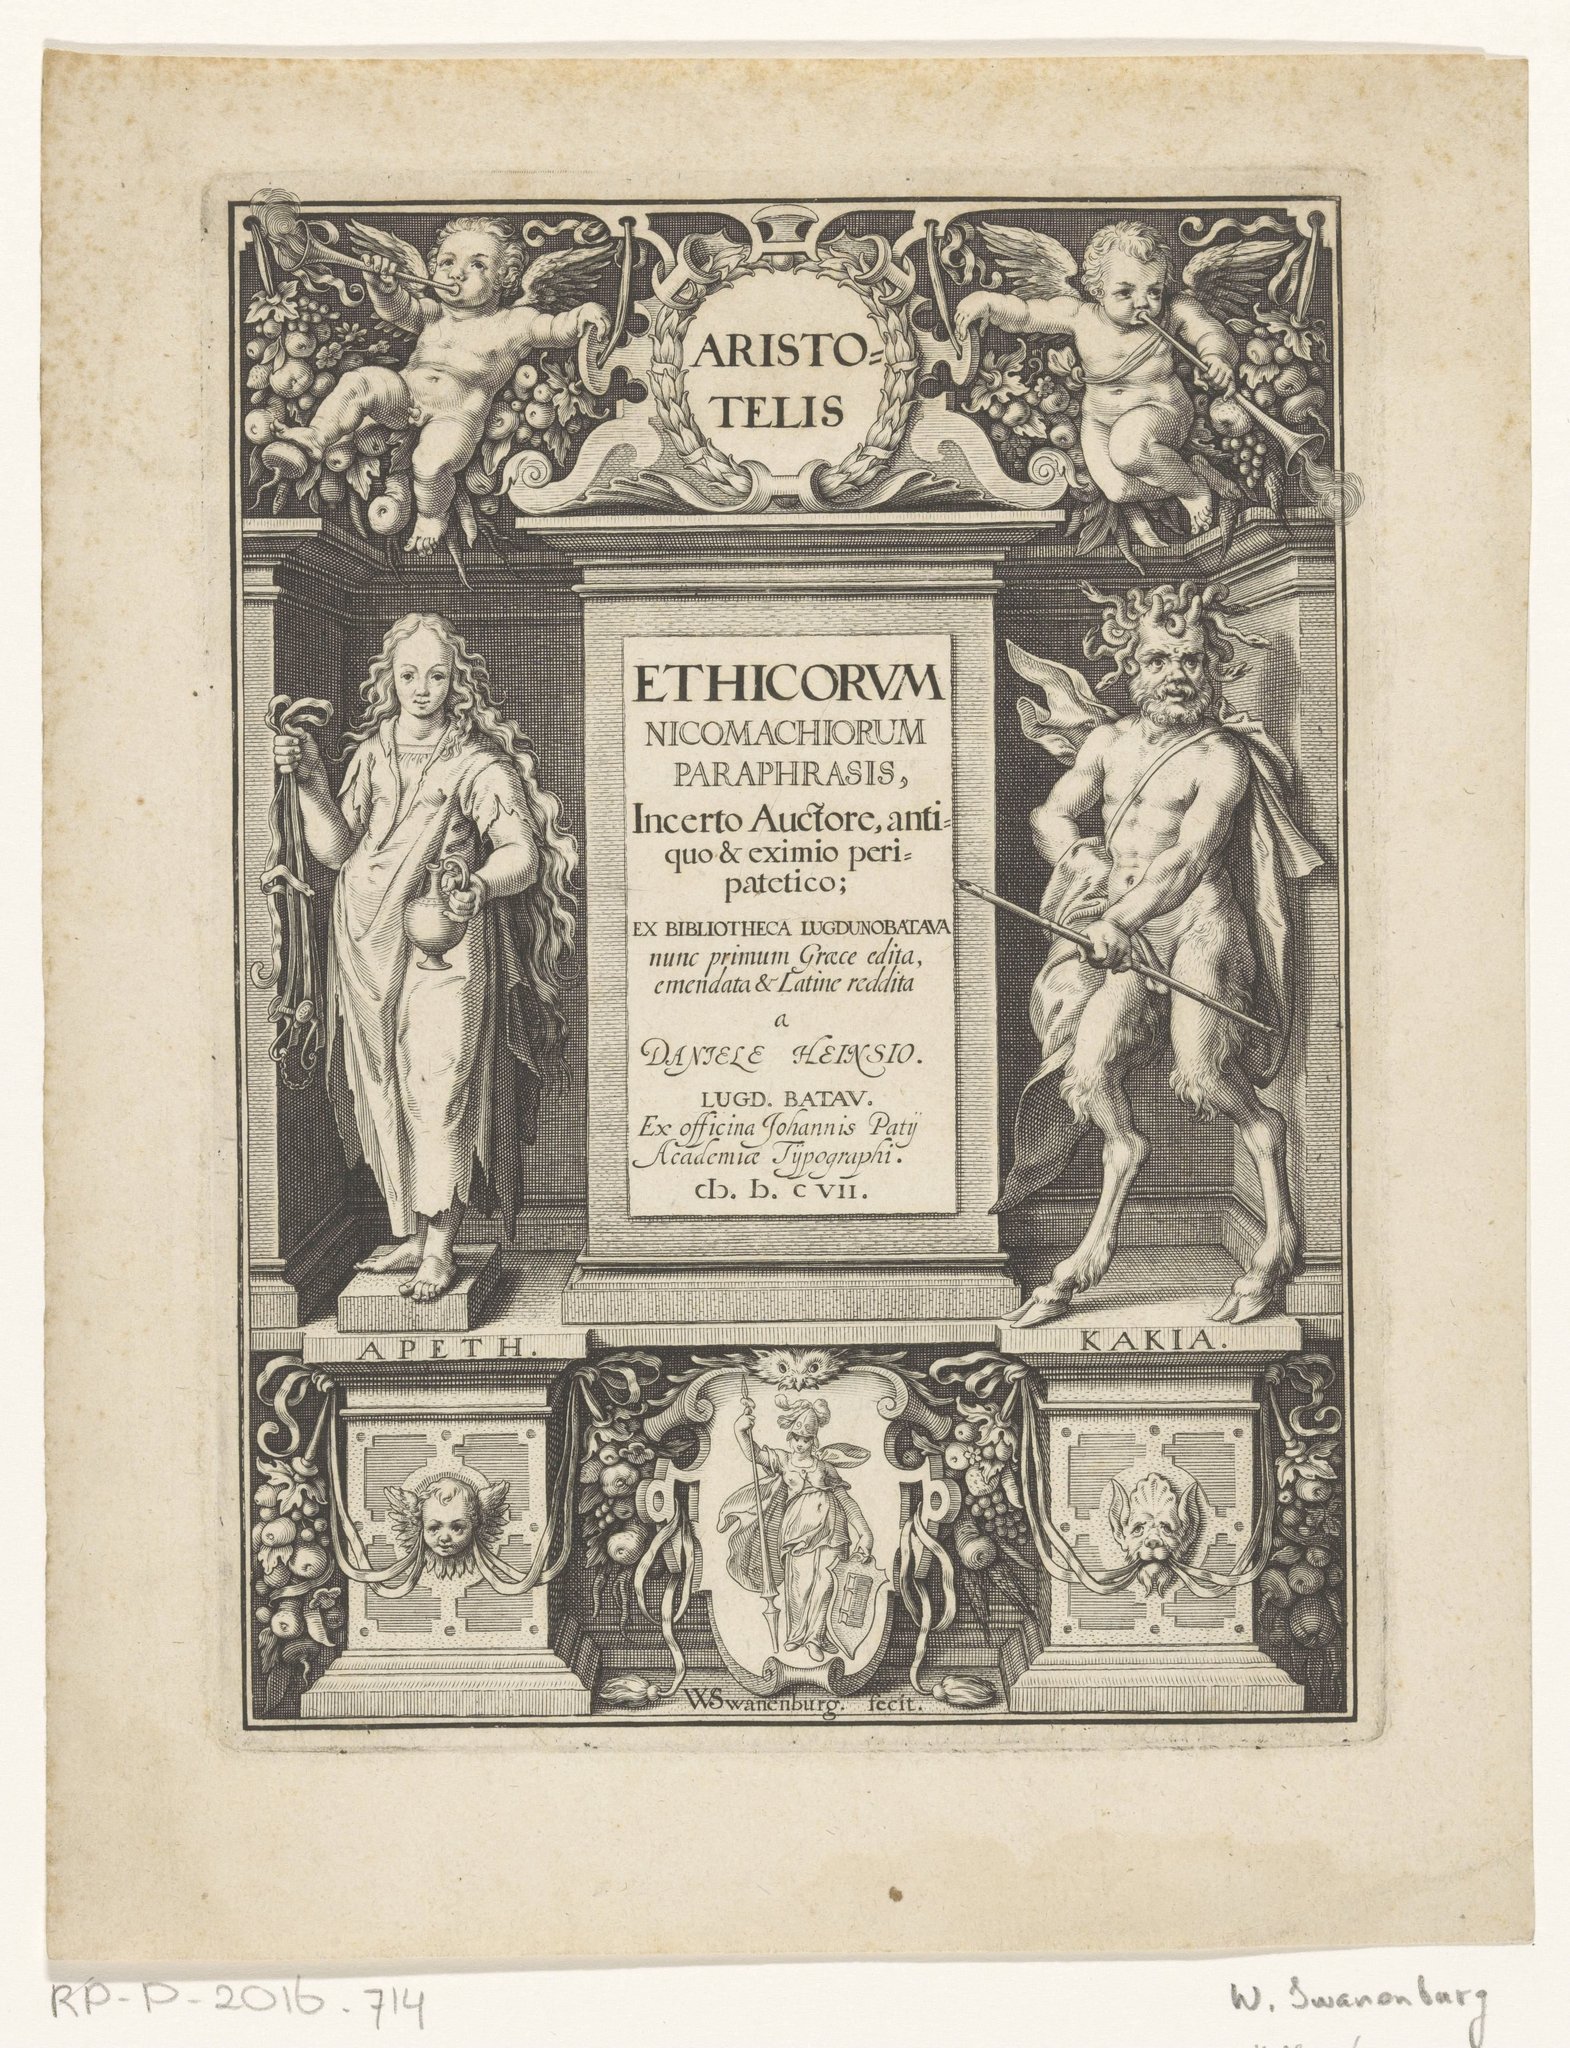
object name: print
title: Titelpagina voor: Daniel Heinsius, Aristotelis Ethicorum Nicomachiorum paraphrasis, 1607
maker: willem isaacsz. van swanenburg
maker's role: print maker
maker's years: 1580-1612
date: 1607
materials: paper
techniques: engraving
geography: leiden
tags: temperance, 'temperantia'; 'temperanza' (ripa) ~ one of the four cardinal virtues, temperance, moderation; 'misura' (ripa), rage, anger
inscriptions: collector's mark: Lugt 2228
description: Op een voetstuk staat links de Deugd met een paardentoom voor matigheid in de ene hand en een kruikje in de andere hand. Rechts staat Kwaadaardigheid, een sater met slangen als haar. Midden onder een cartouche met Minerva. Links en rechts boven twee trompet blazende putti.